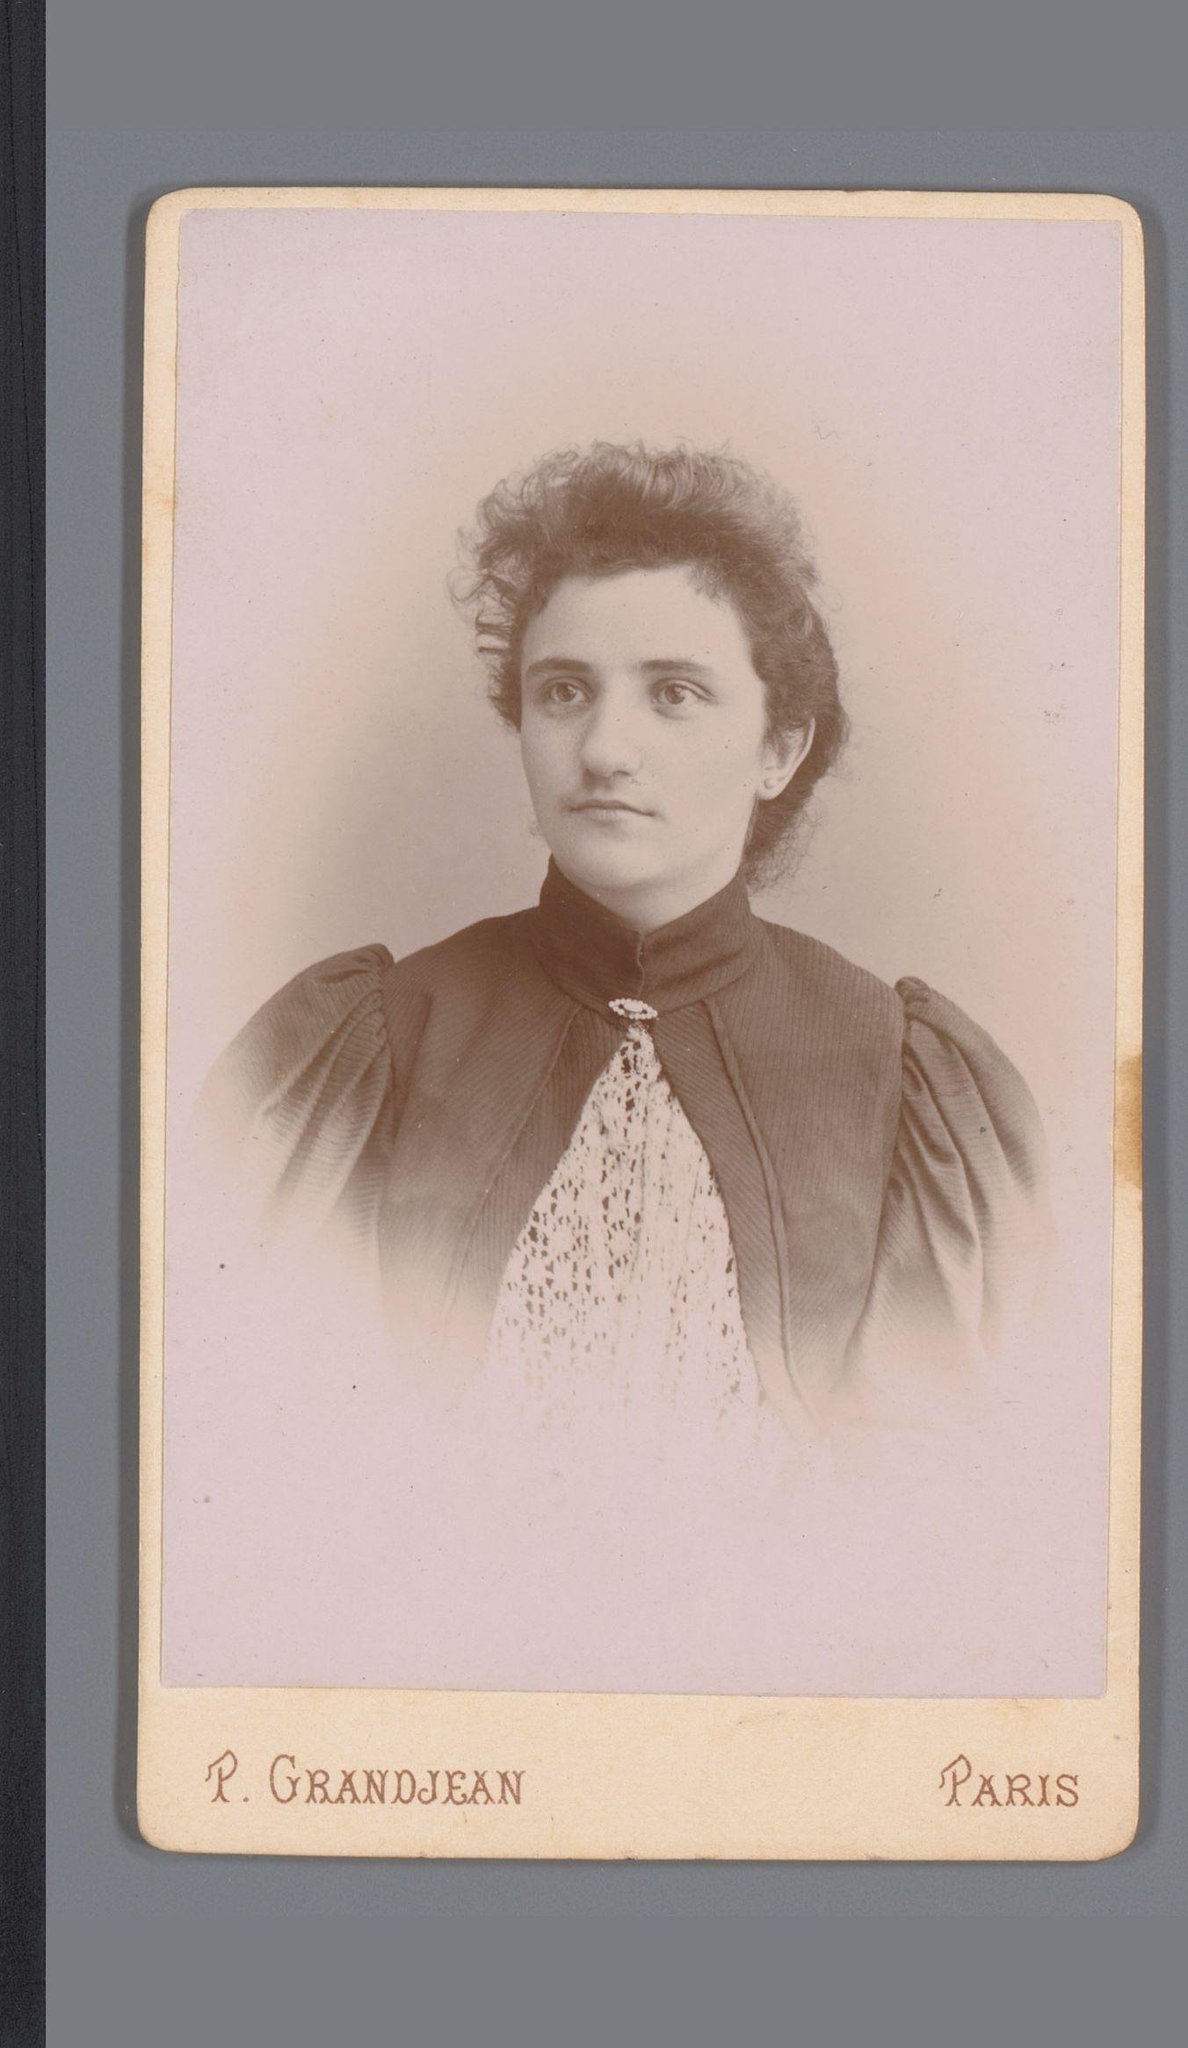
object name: photograph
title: Portret van een onbekende vrouw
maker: pierre grandjean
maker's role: fotograaf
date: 1900-1914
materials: paper, cardboard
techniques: collodion silver print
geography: paris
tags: adult woman, anonymous historical person portrayed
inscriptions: address: ‘24, Rue du Château d'Eau, 24/ PARIS’, inscription: ‘Tous les Clichés sont conservés/ J. H. Nacivet, Paris.’